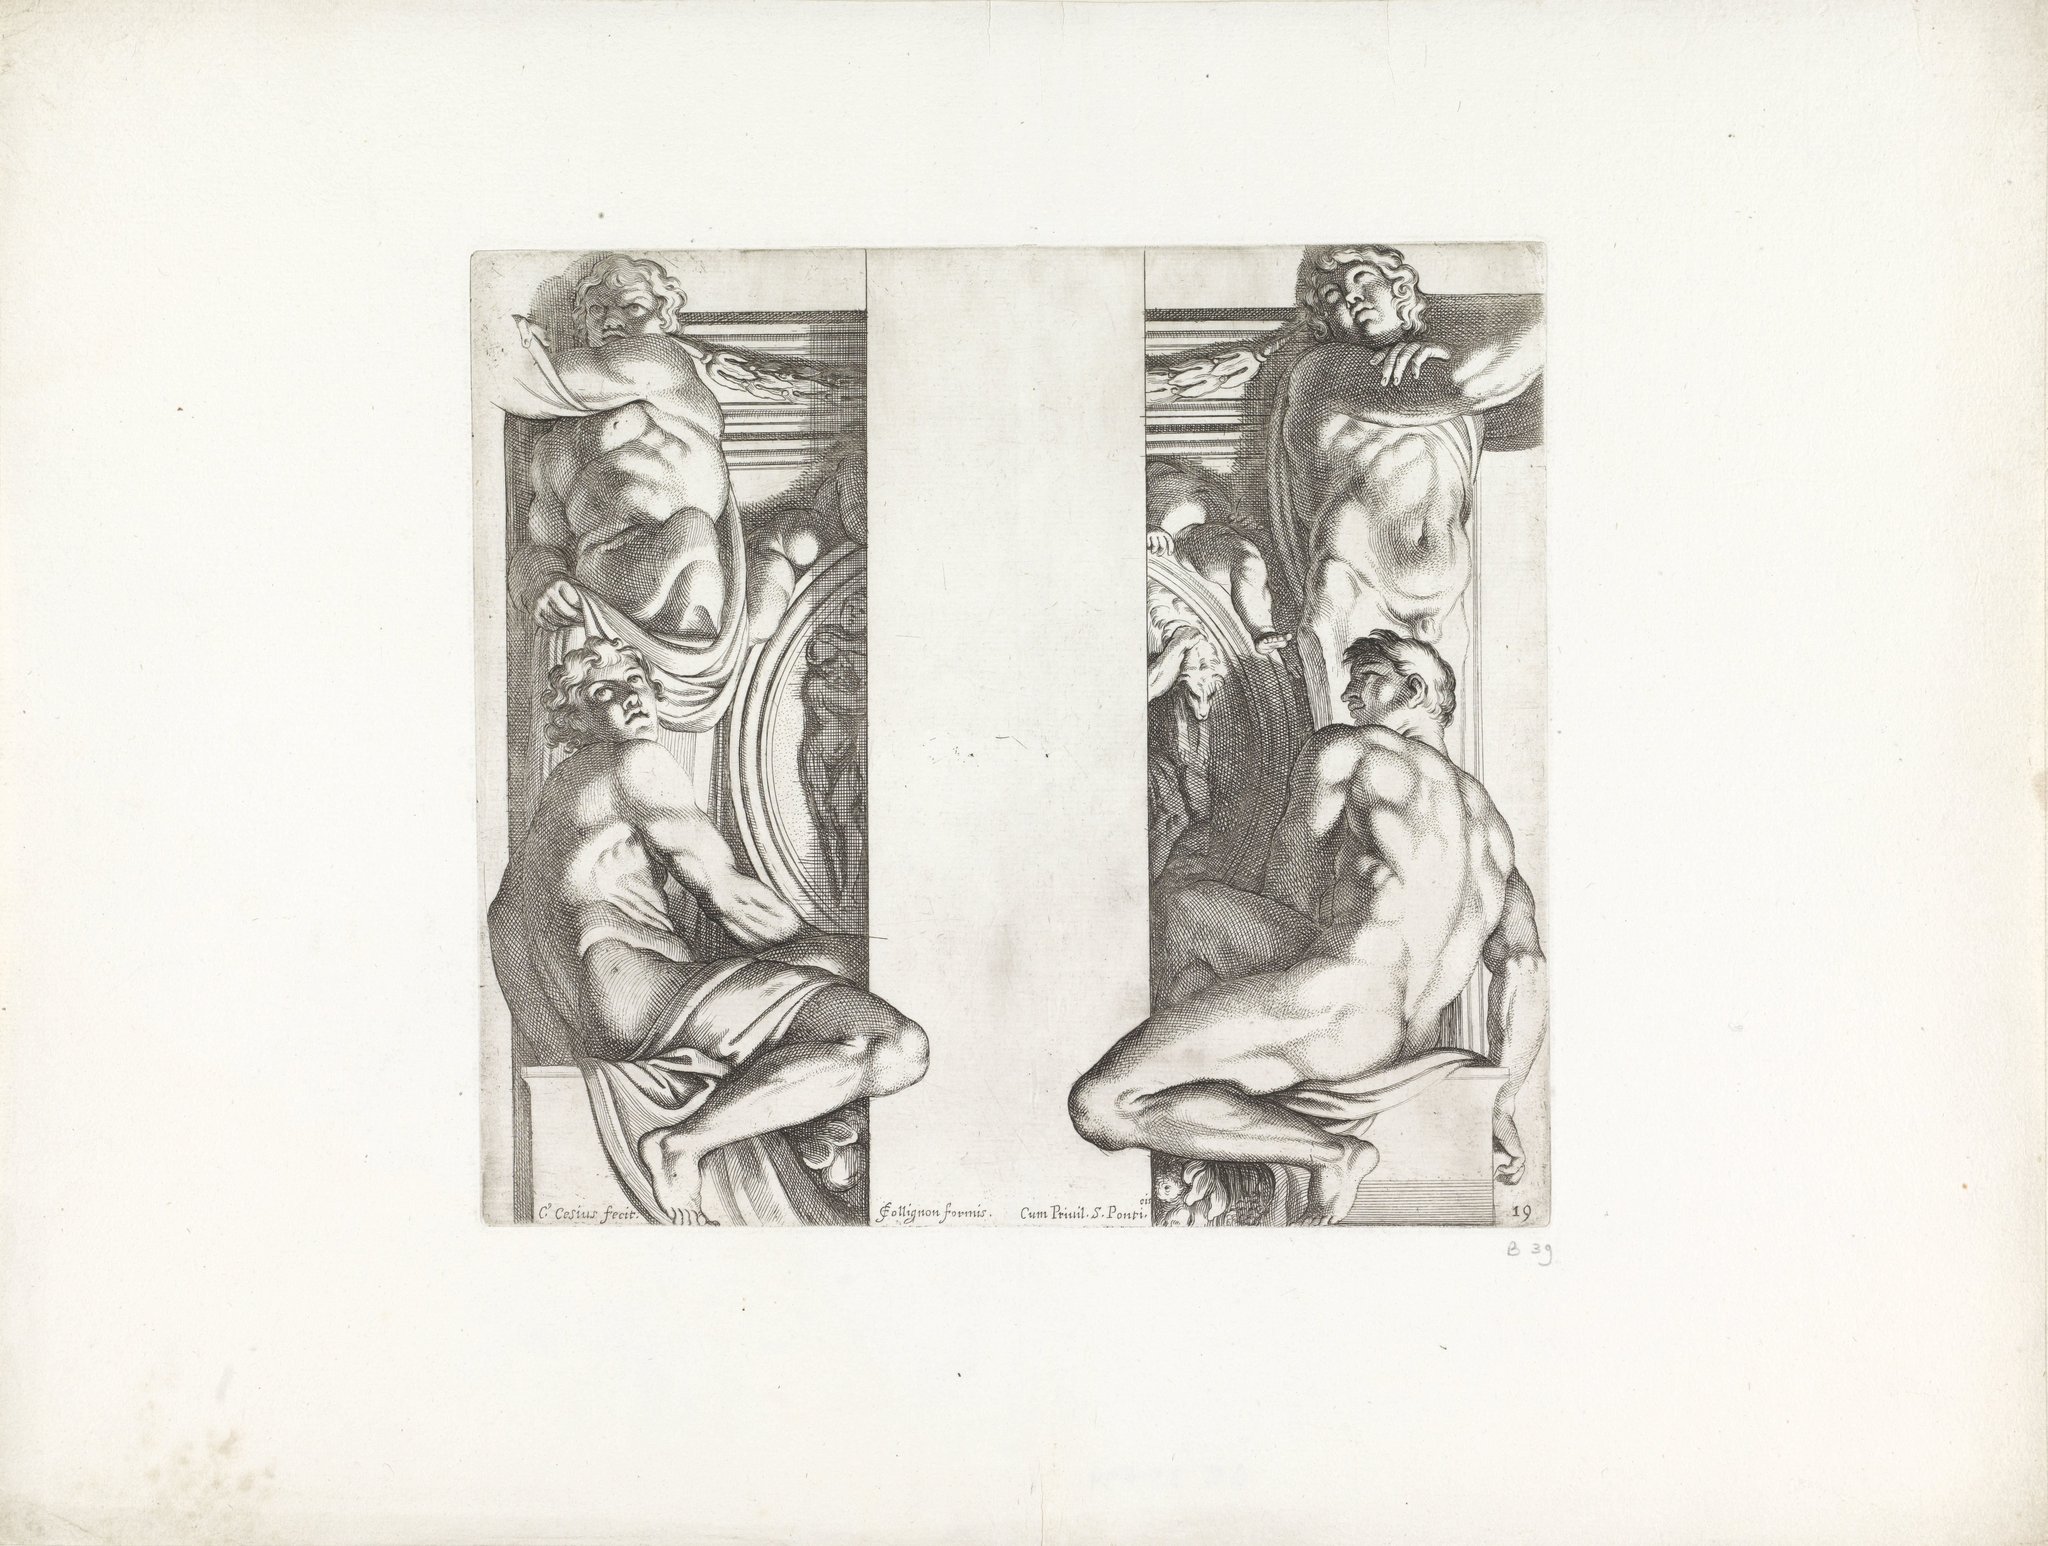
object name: print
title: Schilderingen in Palazzo Farnese te Rome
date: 1656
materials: paper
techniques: etching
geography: rome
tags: the (nude) human figure; 'corpo humano' (ripa), cupids: 'amores', 'amoretti', 'putti'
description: Prent uit een reeks prenten met nummers van 1 tot en met 29 (sommige prenten hebben hetzelfde nummer), plus titelprent en opdracht, naar schilderingen in Palazzo Farnese te Rome.